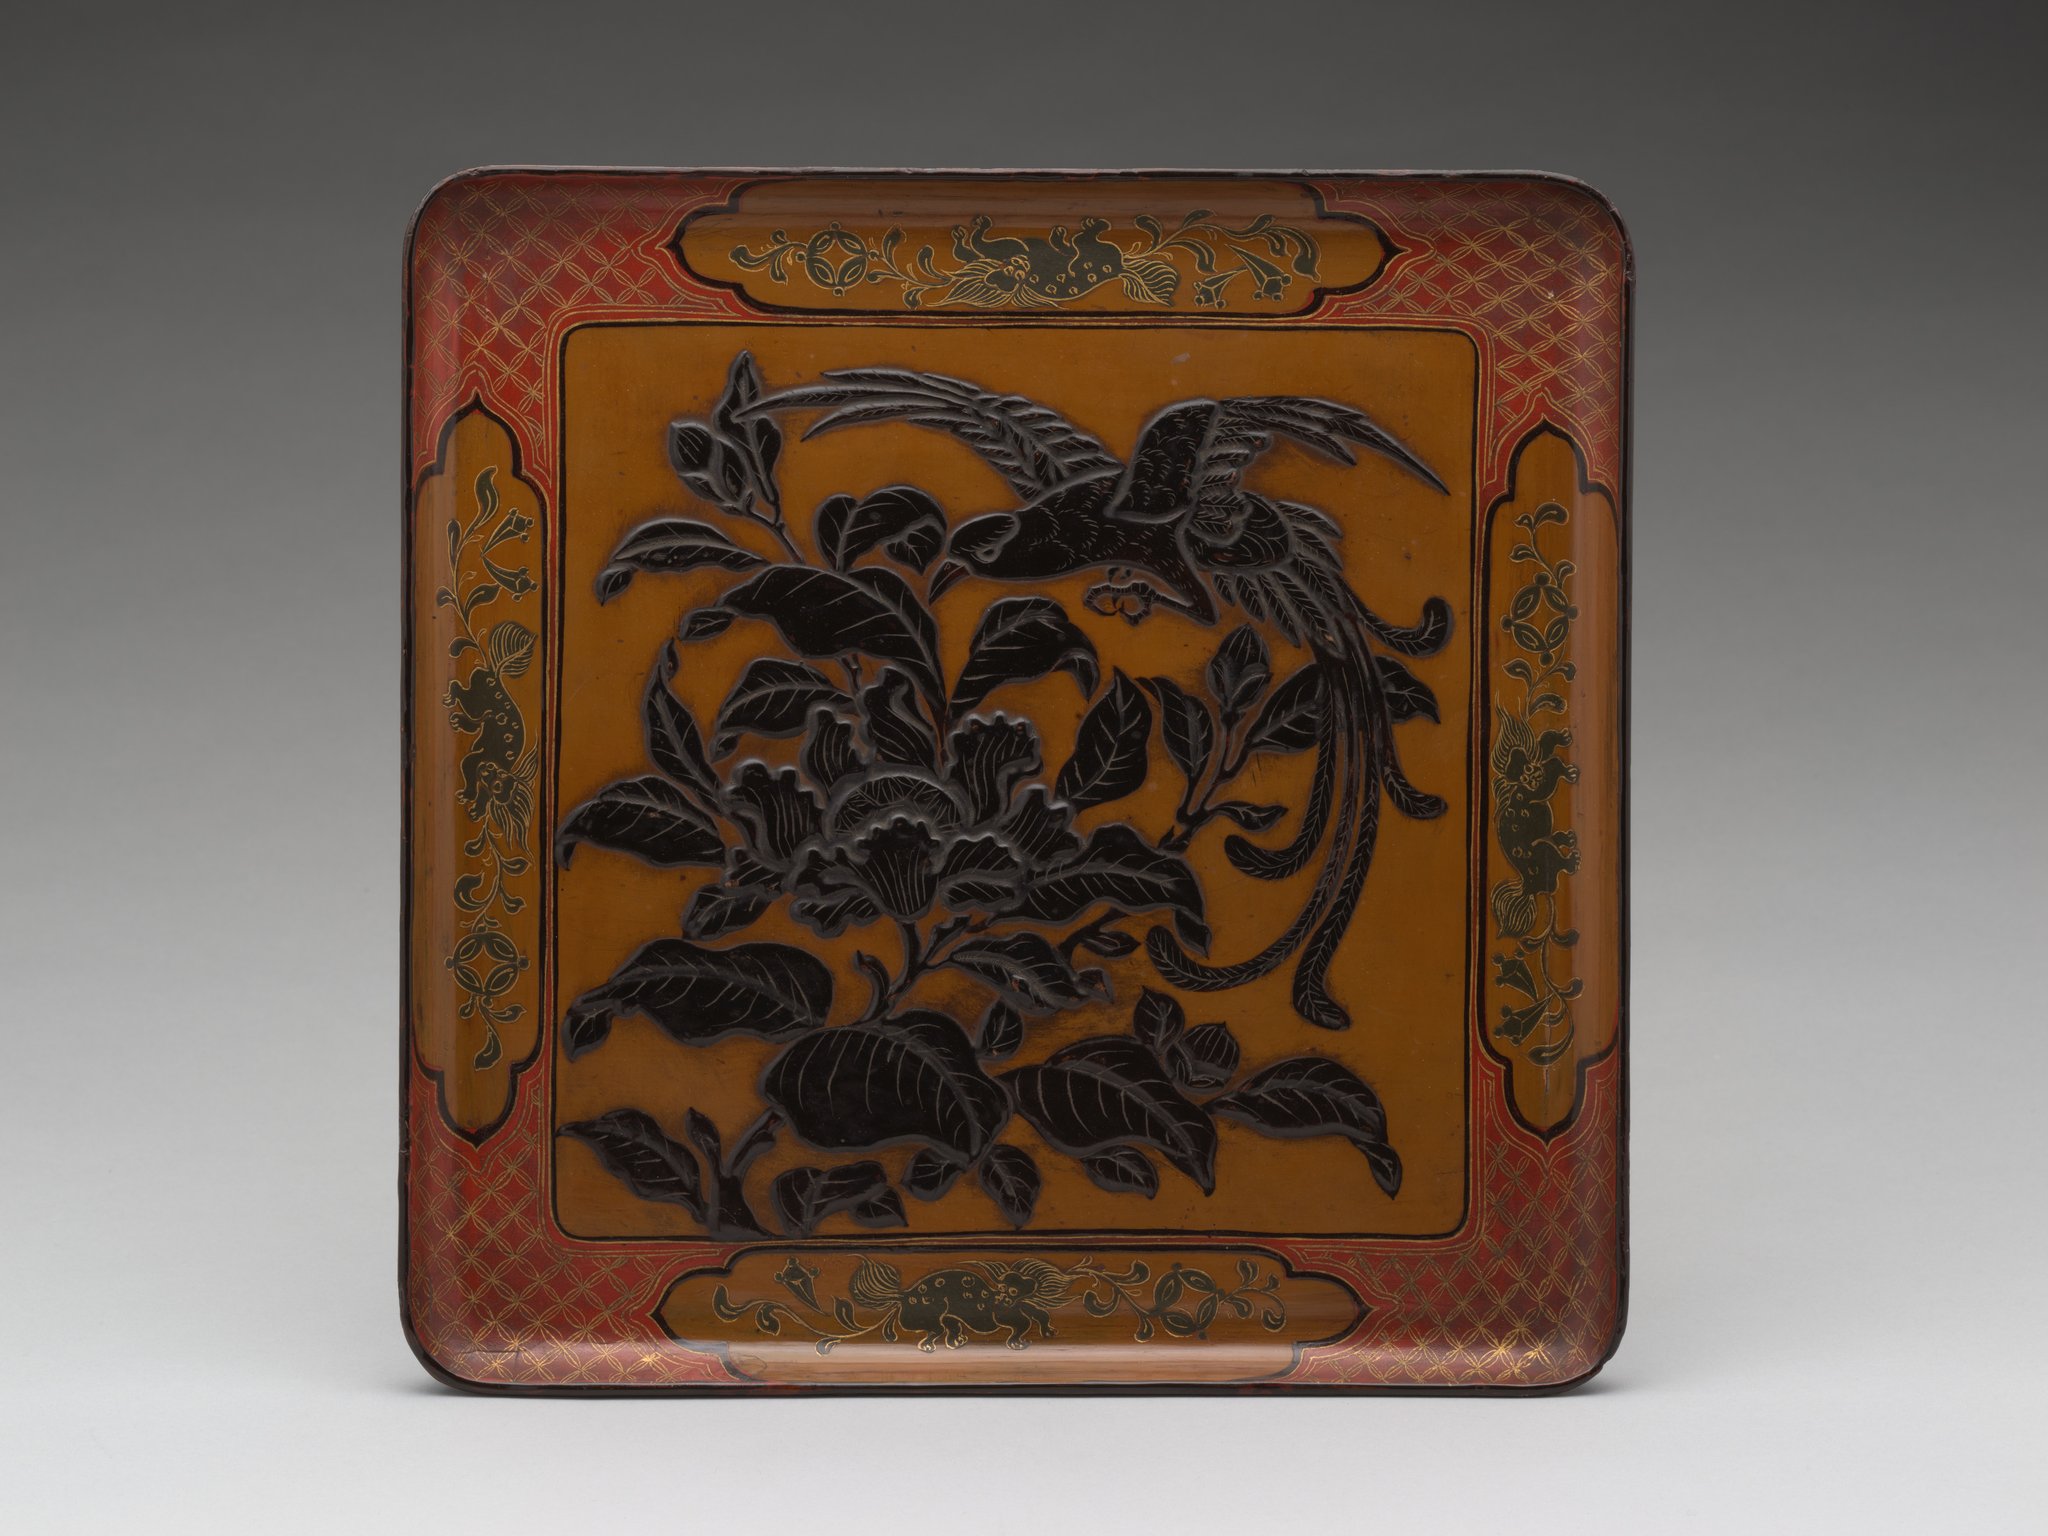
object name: tray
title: Square tray with flower-and-bird decoration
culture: japanese or ryukyuan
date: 1701-1800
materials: lacquer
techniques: polychrome